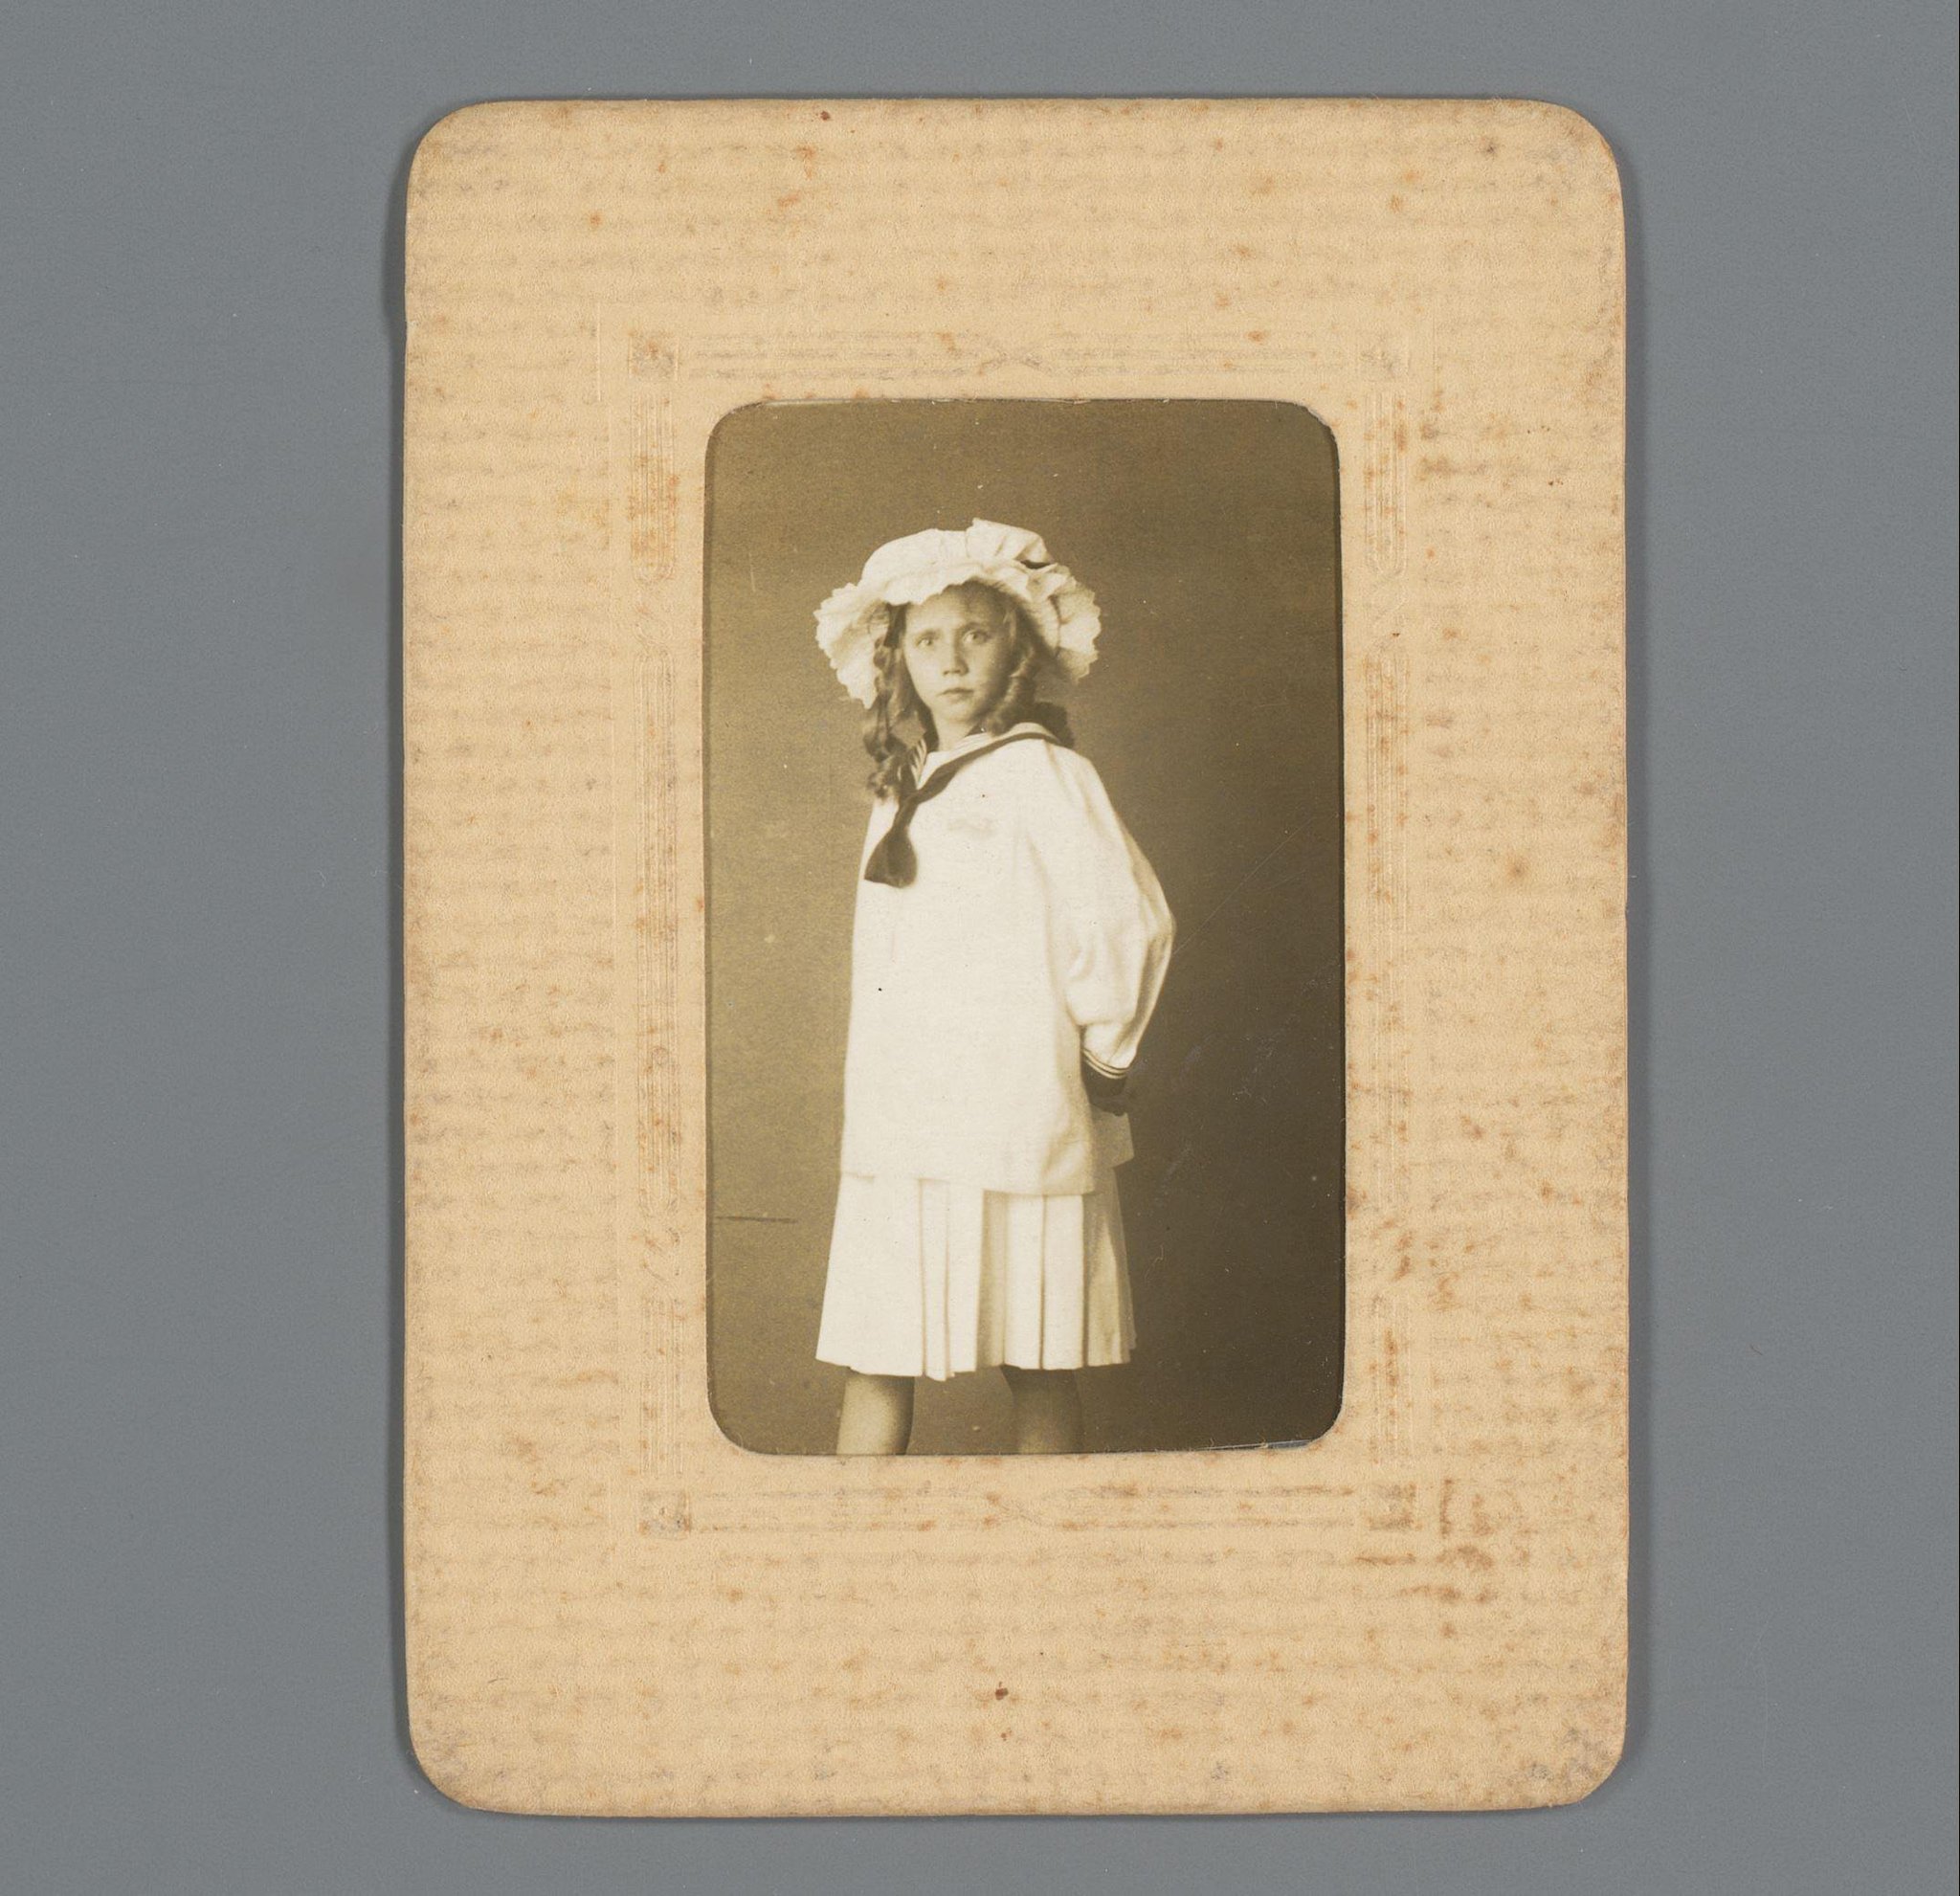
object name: snapshot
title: Portret van een onbekend meisje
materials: paper, cardboard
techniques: gelatin silver print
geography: amsterdam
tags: girl (child between toddler and youth), anonymous historical person portrayed, amsterdam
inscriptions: inscription: ‘AMERICAN AUTOMATIC FOTOGRAFIE/ Kalverstraat 155/ AMSTERDAM.’